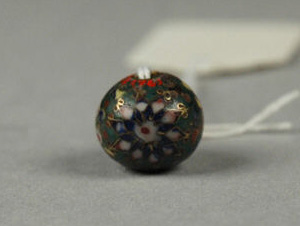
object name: ojime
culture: japanese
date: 1801-1900